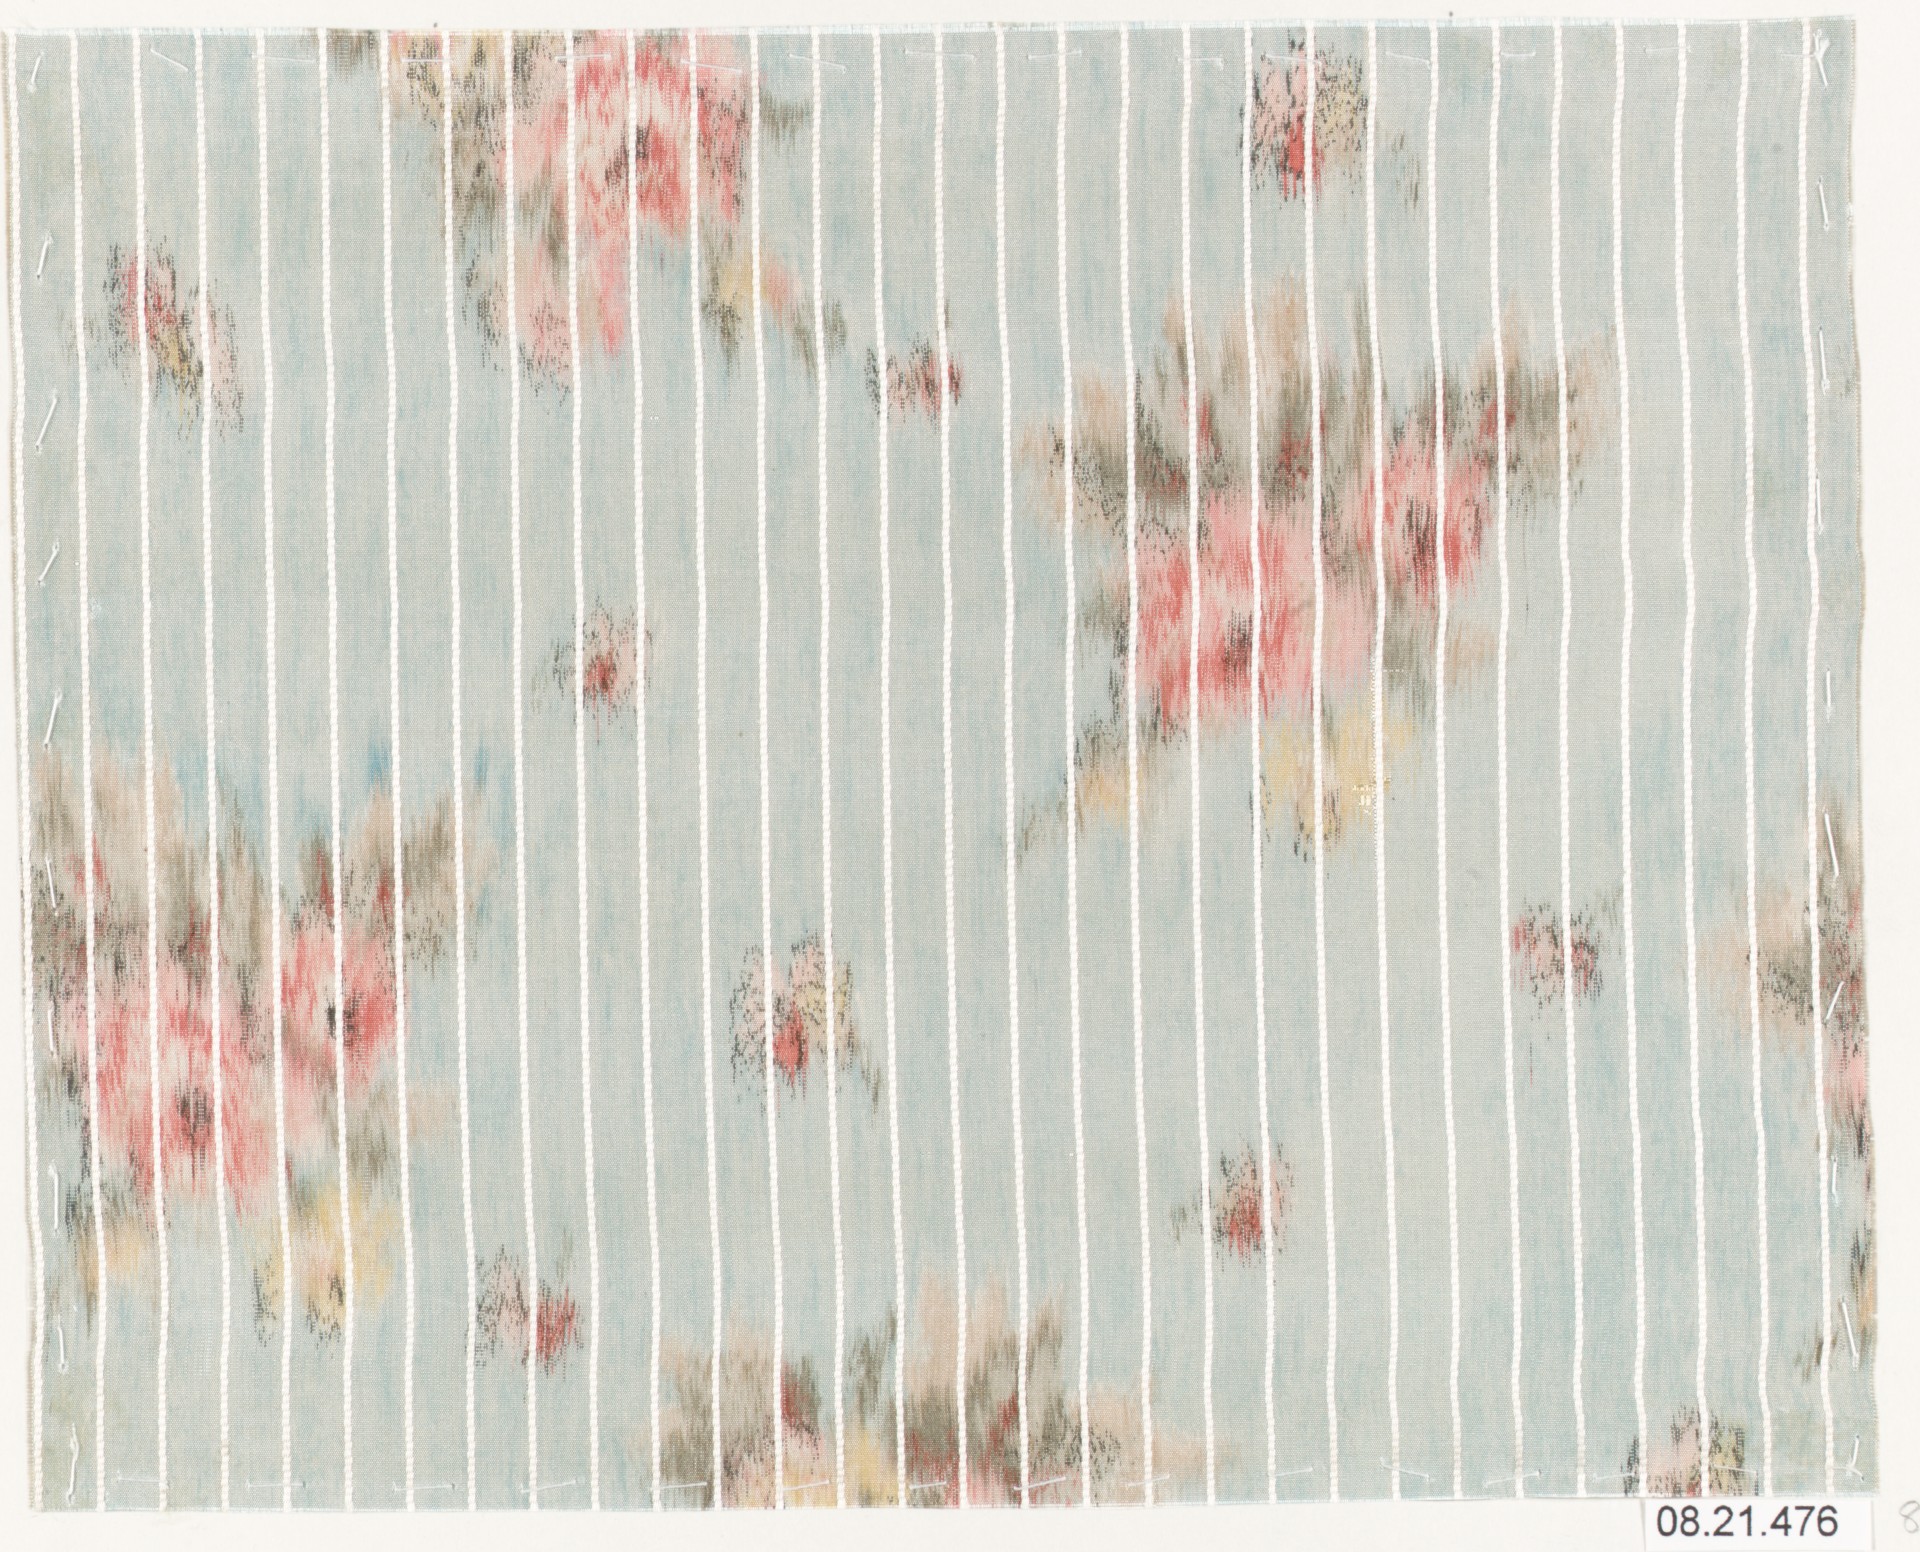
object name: textile sample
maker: Anonymous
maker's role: designer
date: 1900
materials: silk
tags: flowers